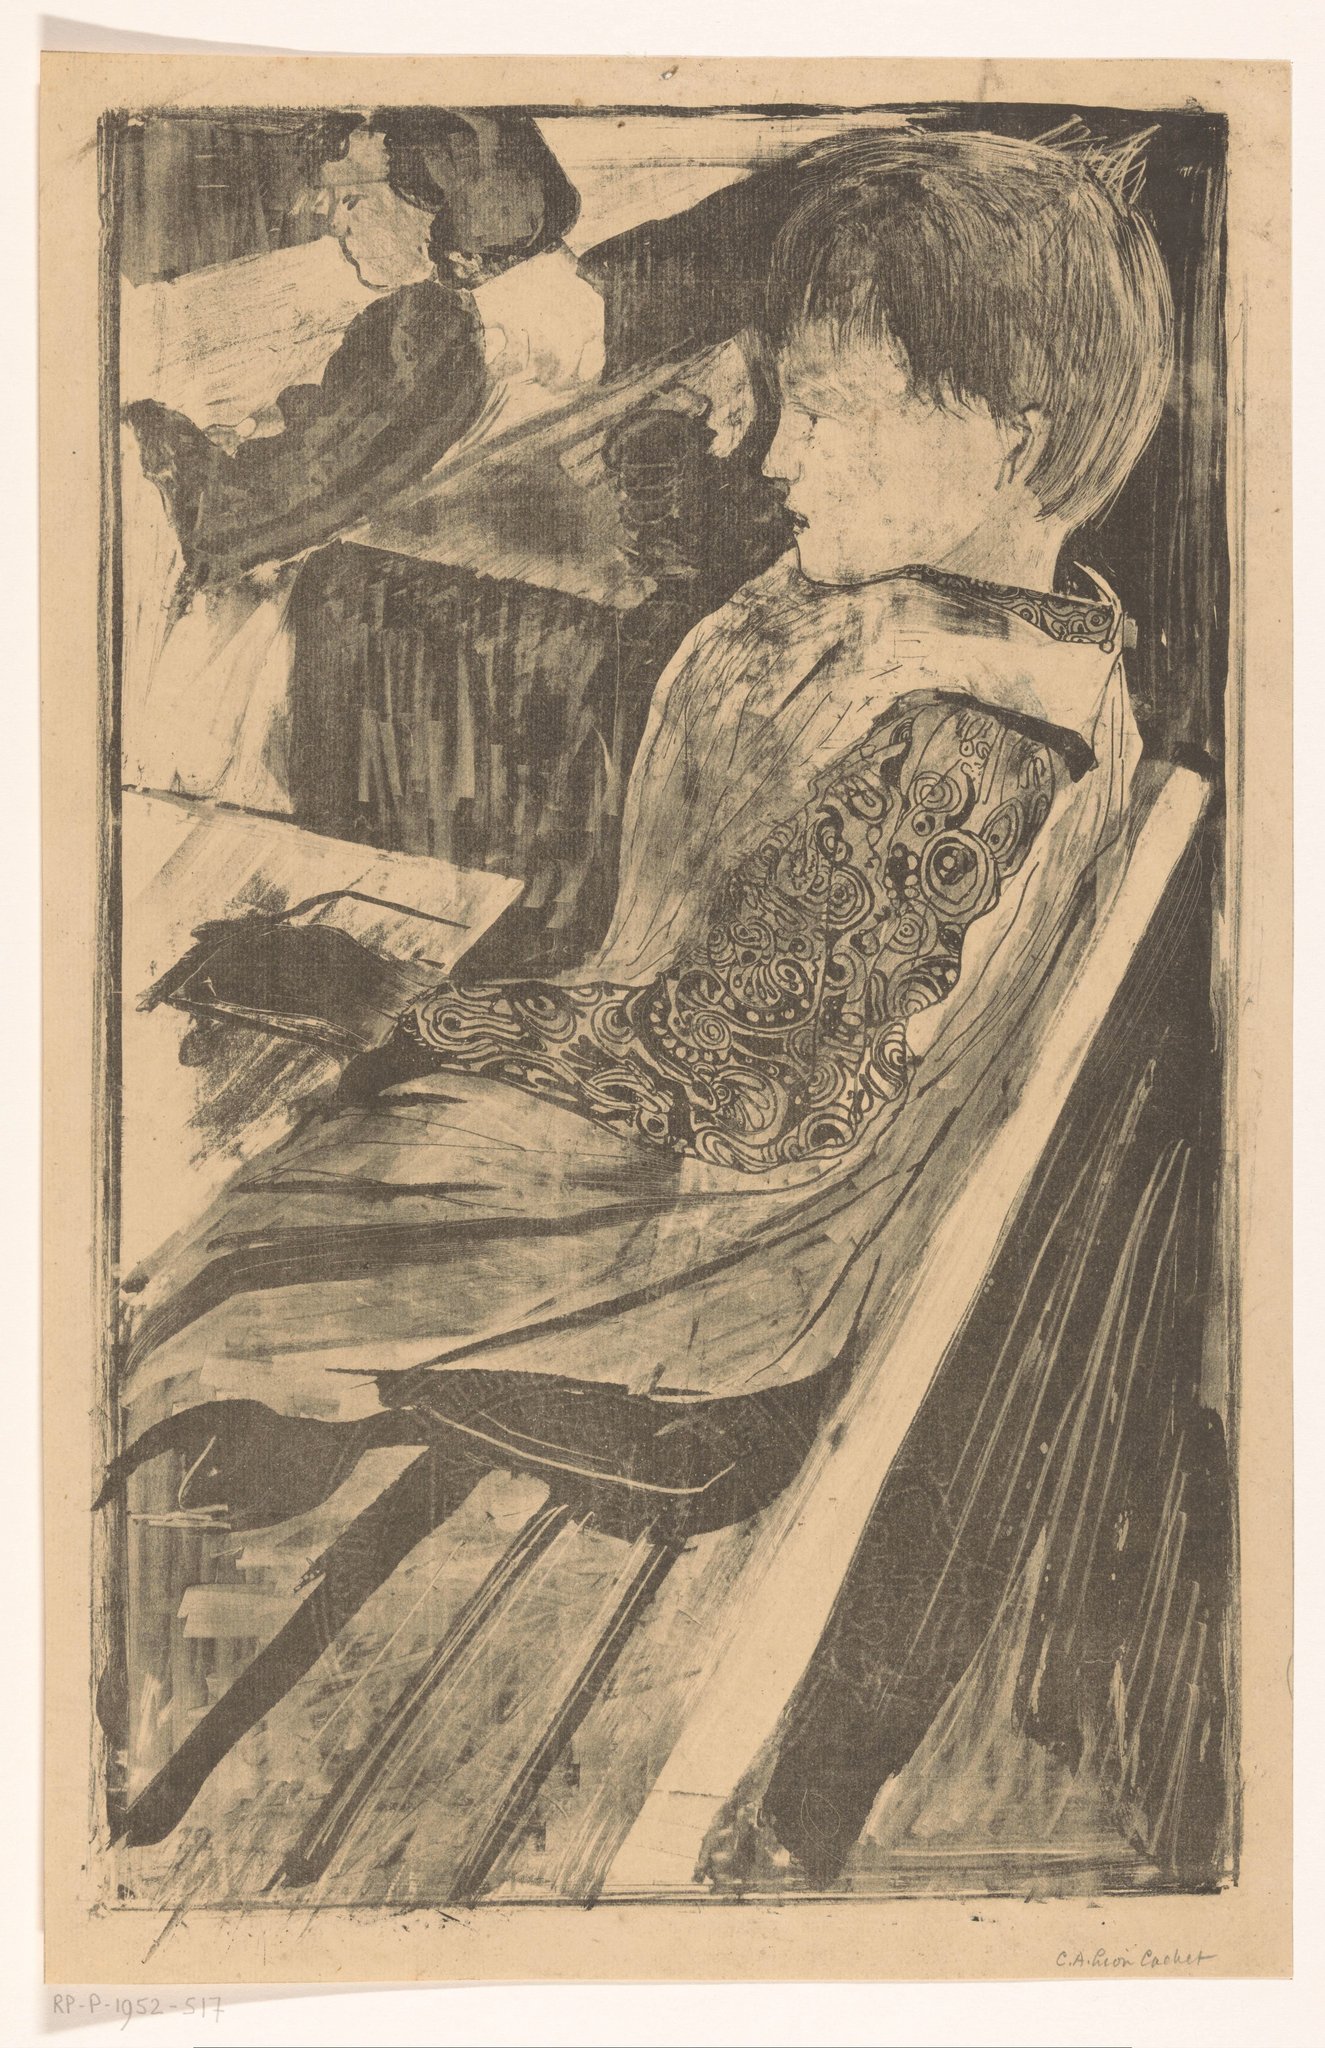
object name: print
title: Kinderen in schoolbanken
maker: carel adolph lion cachet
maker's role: draughtsman, print maker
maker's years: 1864-1945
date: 1874-1945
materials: paper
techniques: lithograph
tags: boy (child between toddler and youth), elementary school; class, form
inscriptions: collector's mark: Lugt 2228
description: Vooraan zit een jongen met op zijn mouw een decoratief patroon.